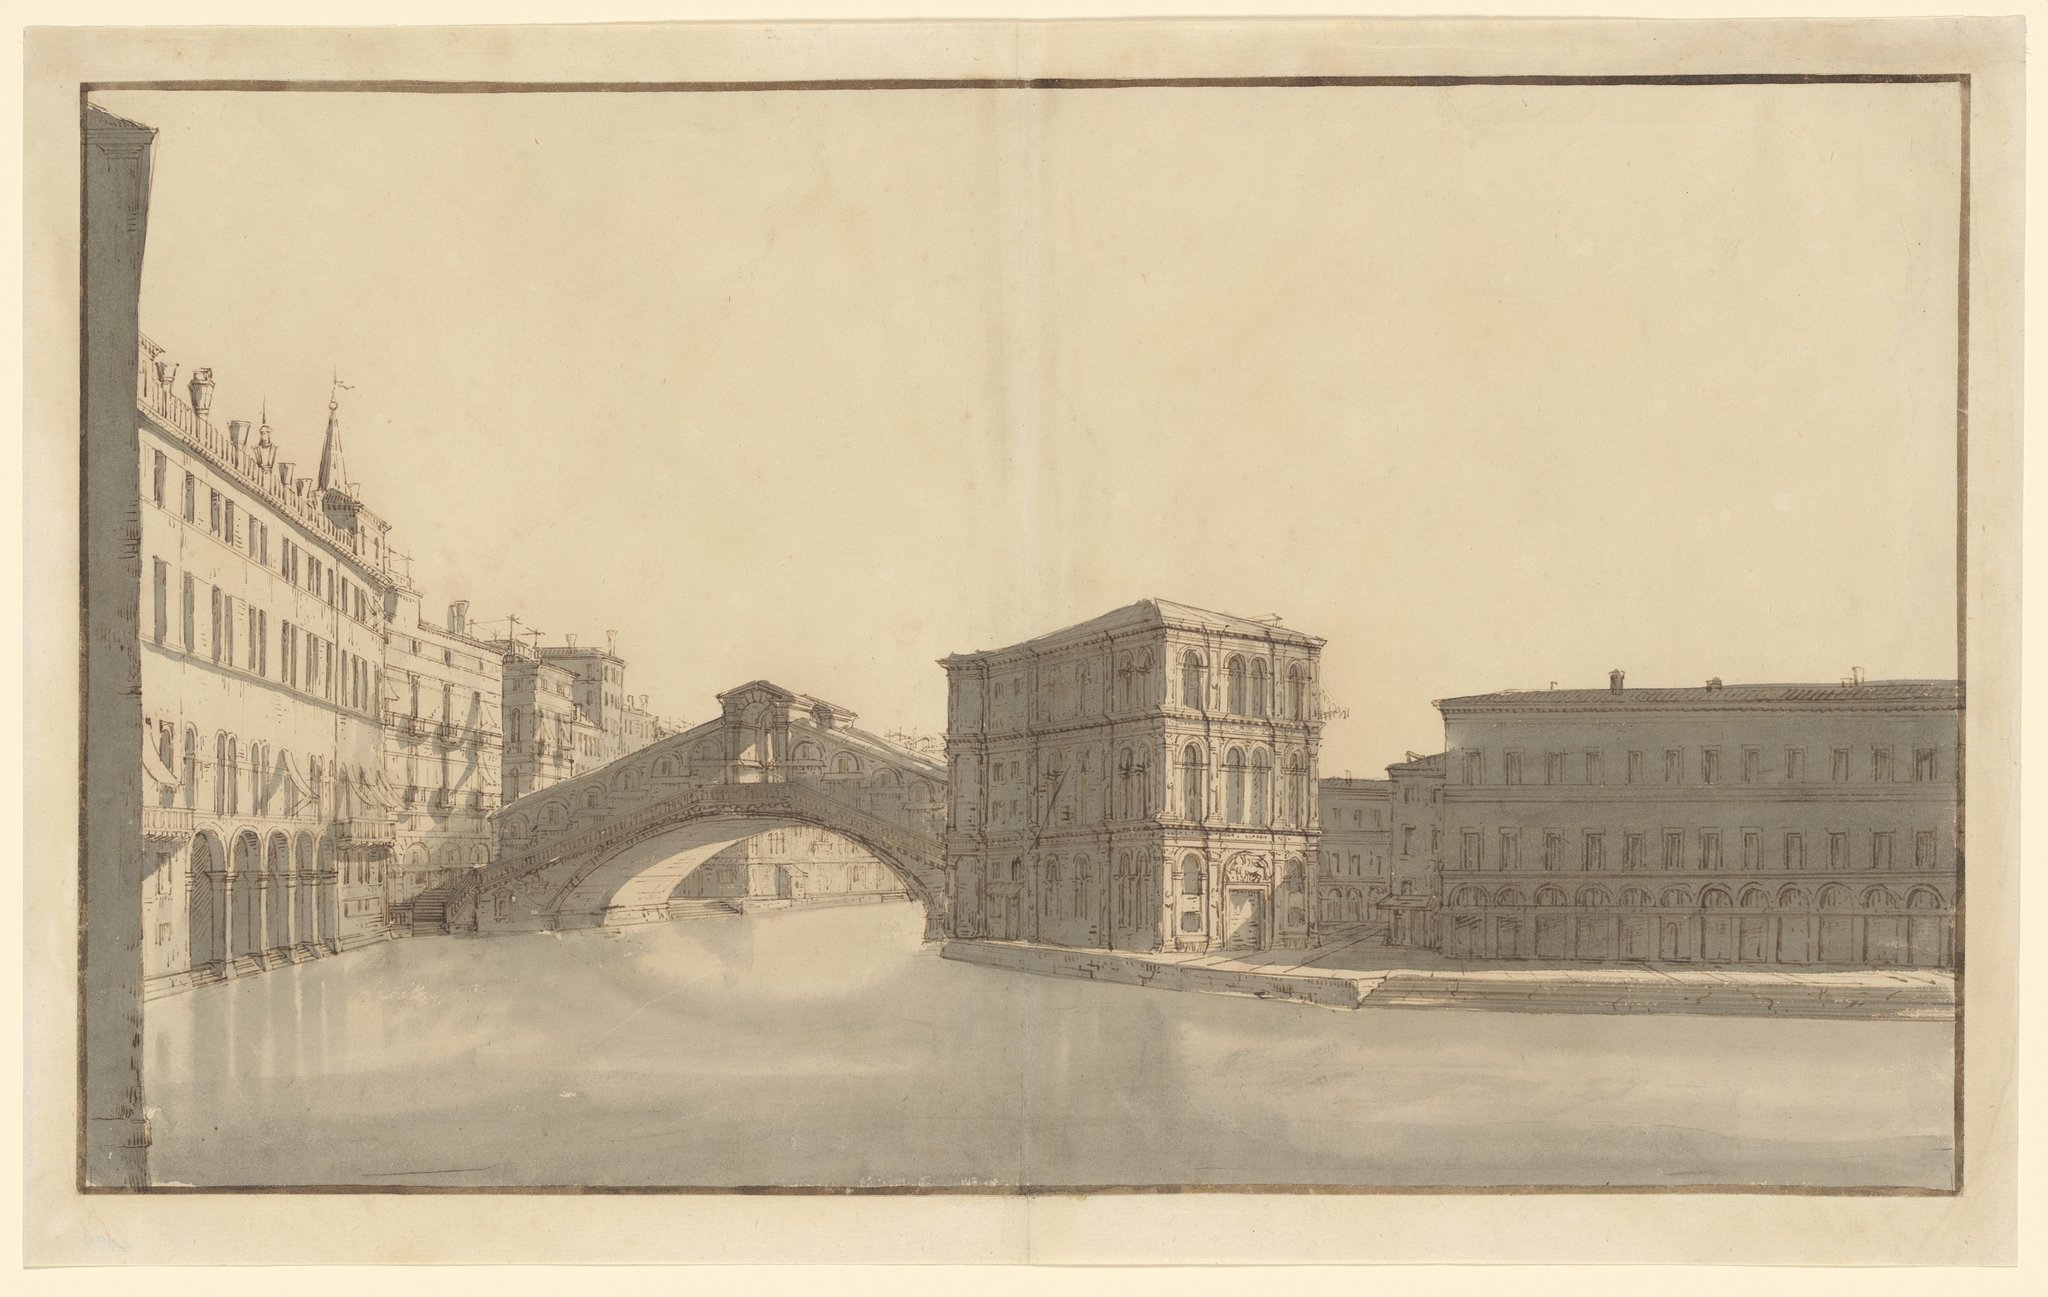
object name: drawing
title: The Grand Canal with the Rialto Bridge, from the North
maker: bernardo bellotto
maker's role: artist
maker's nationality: italian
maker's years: 1722-1780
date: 1736-1737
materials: ink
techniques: pen, wash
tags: cities,bridges,canals